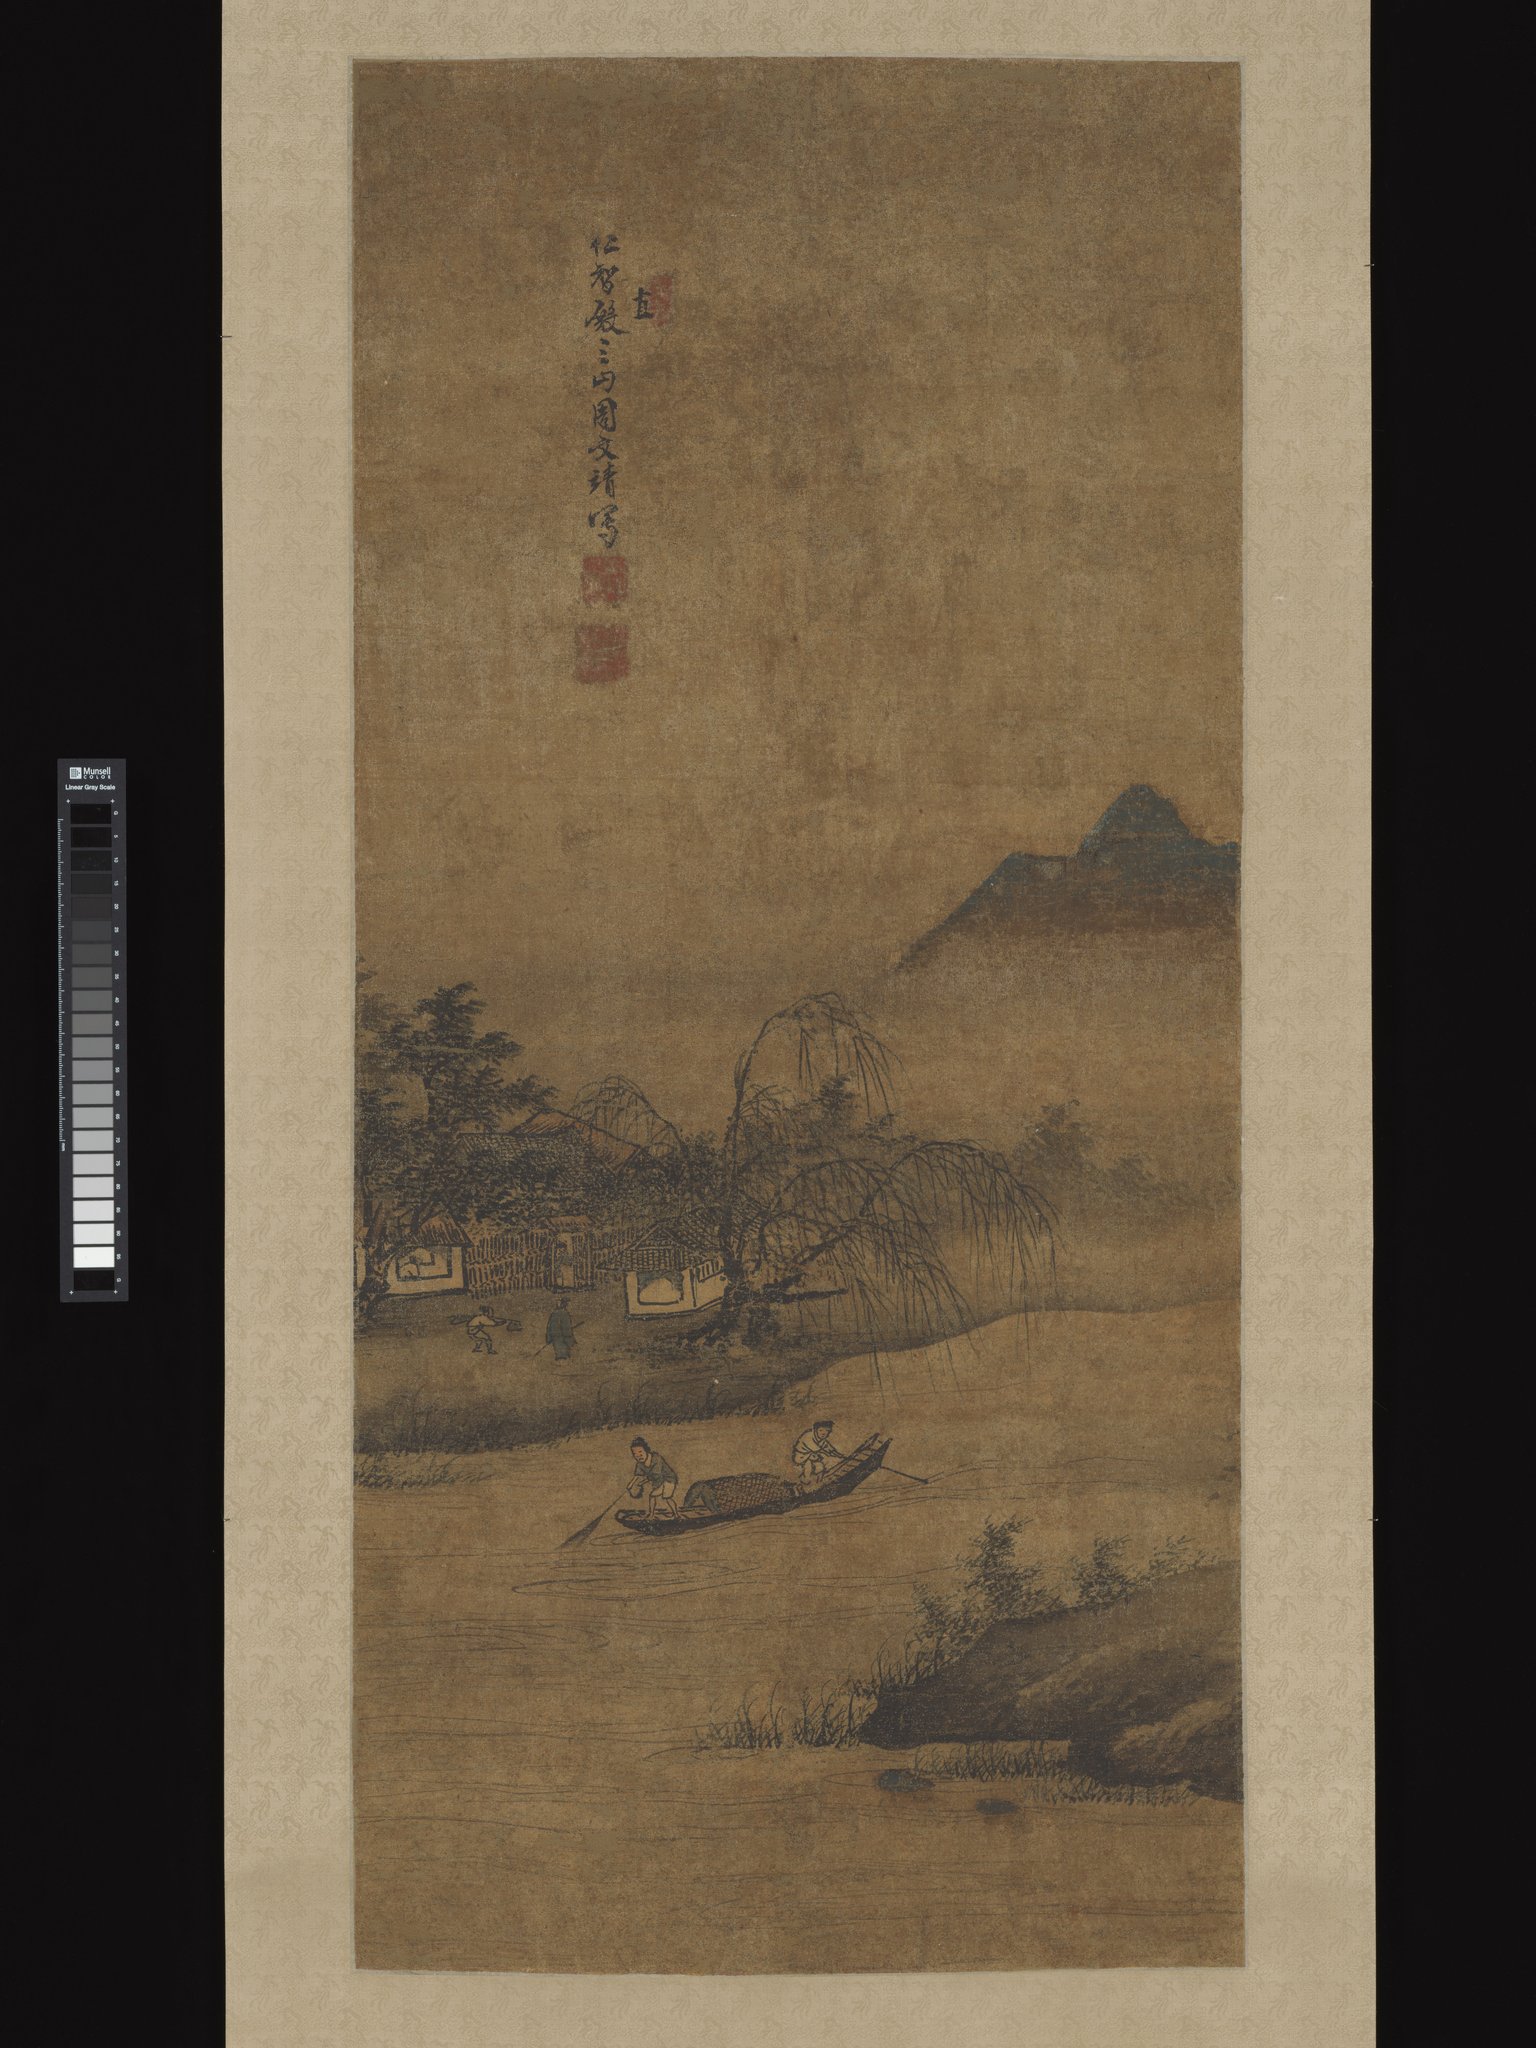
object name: hanging scroll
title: Rustic retreat among fishermen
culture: chinese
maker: zhou wenjing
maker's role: artist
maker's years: 1430-1463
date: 1401-1500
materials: ink, silk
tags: fishing,rivers,boats